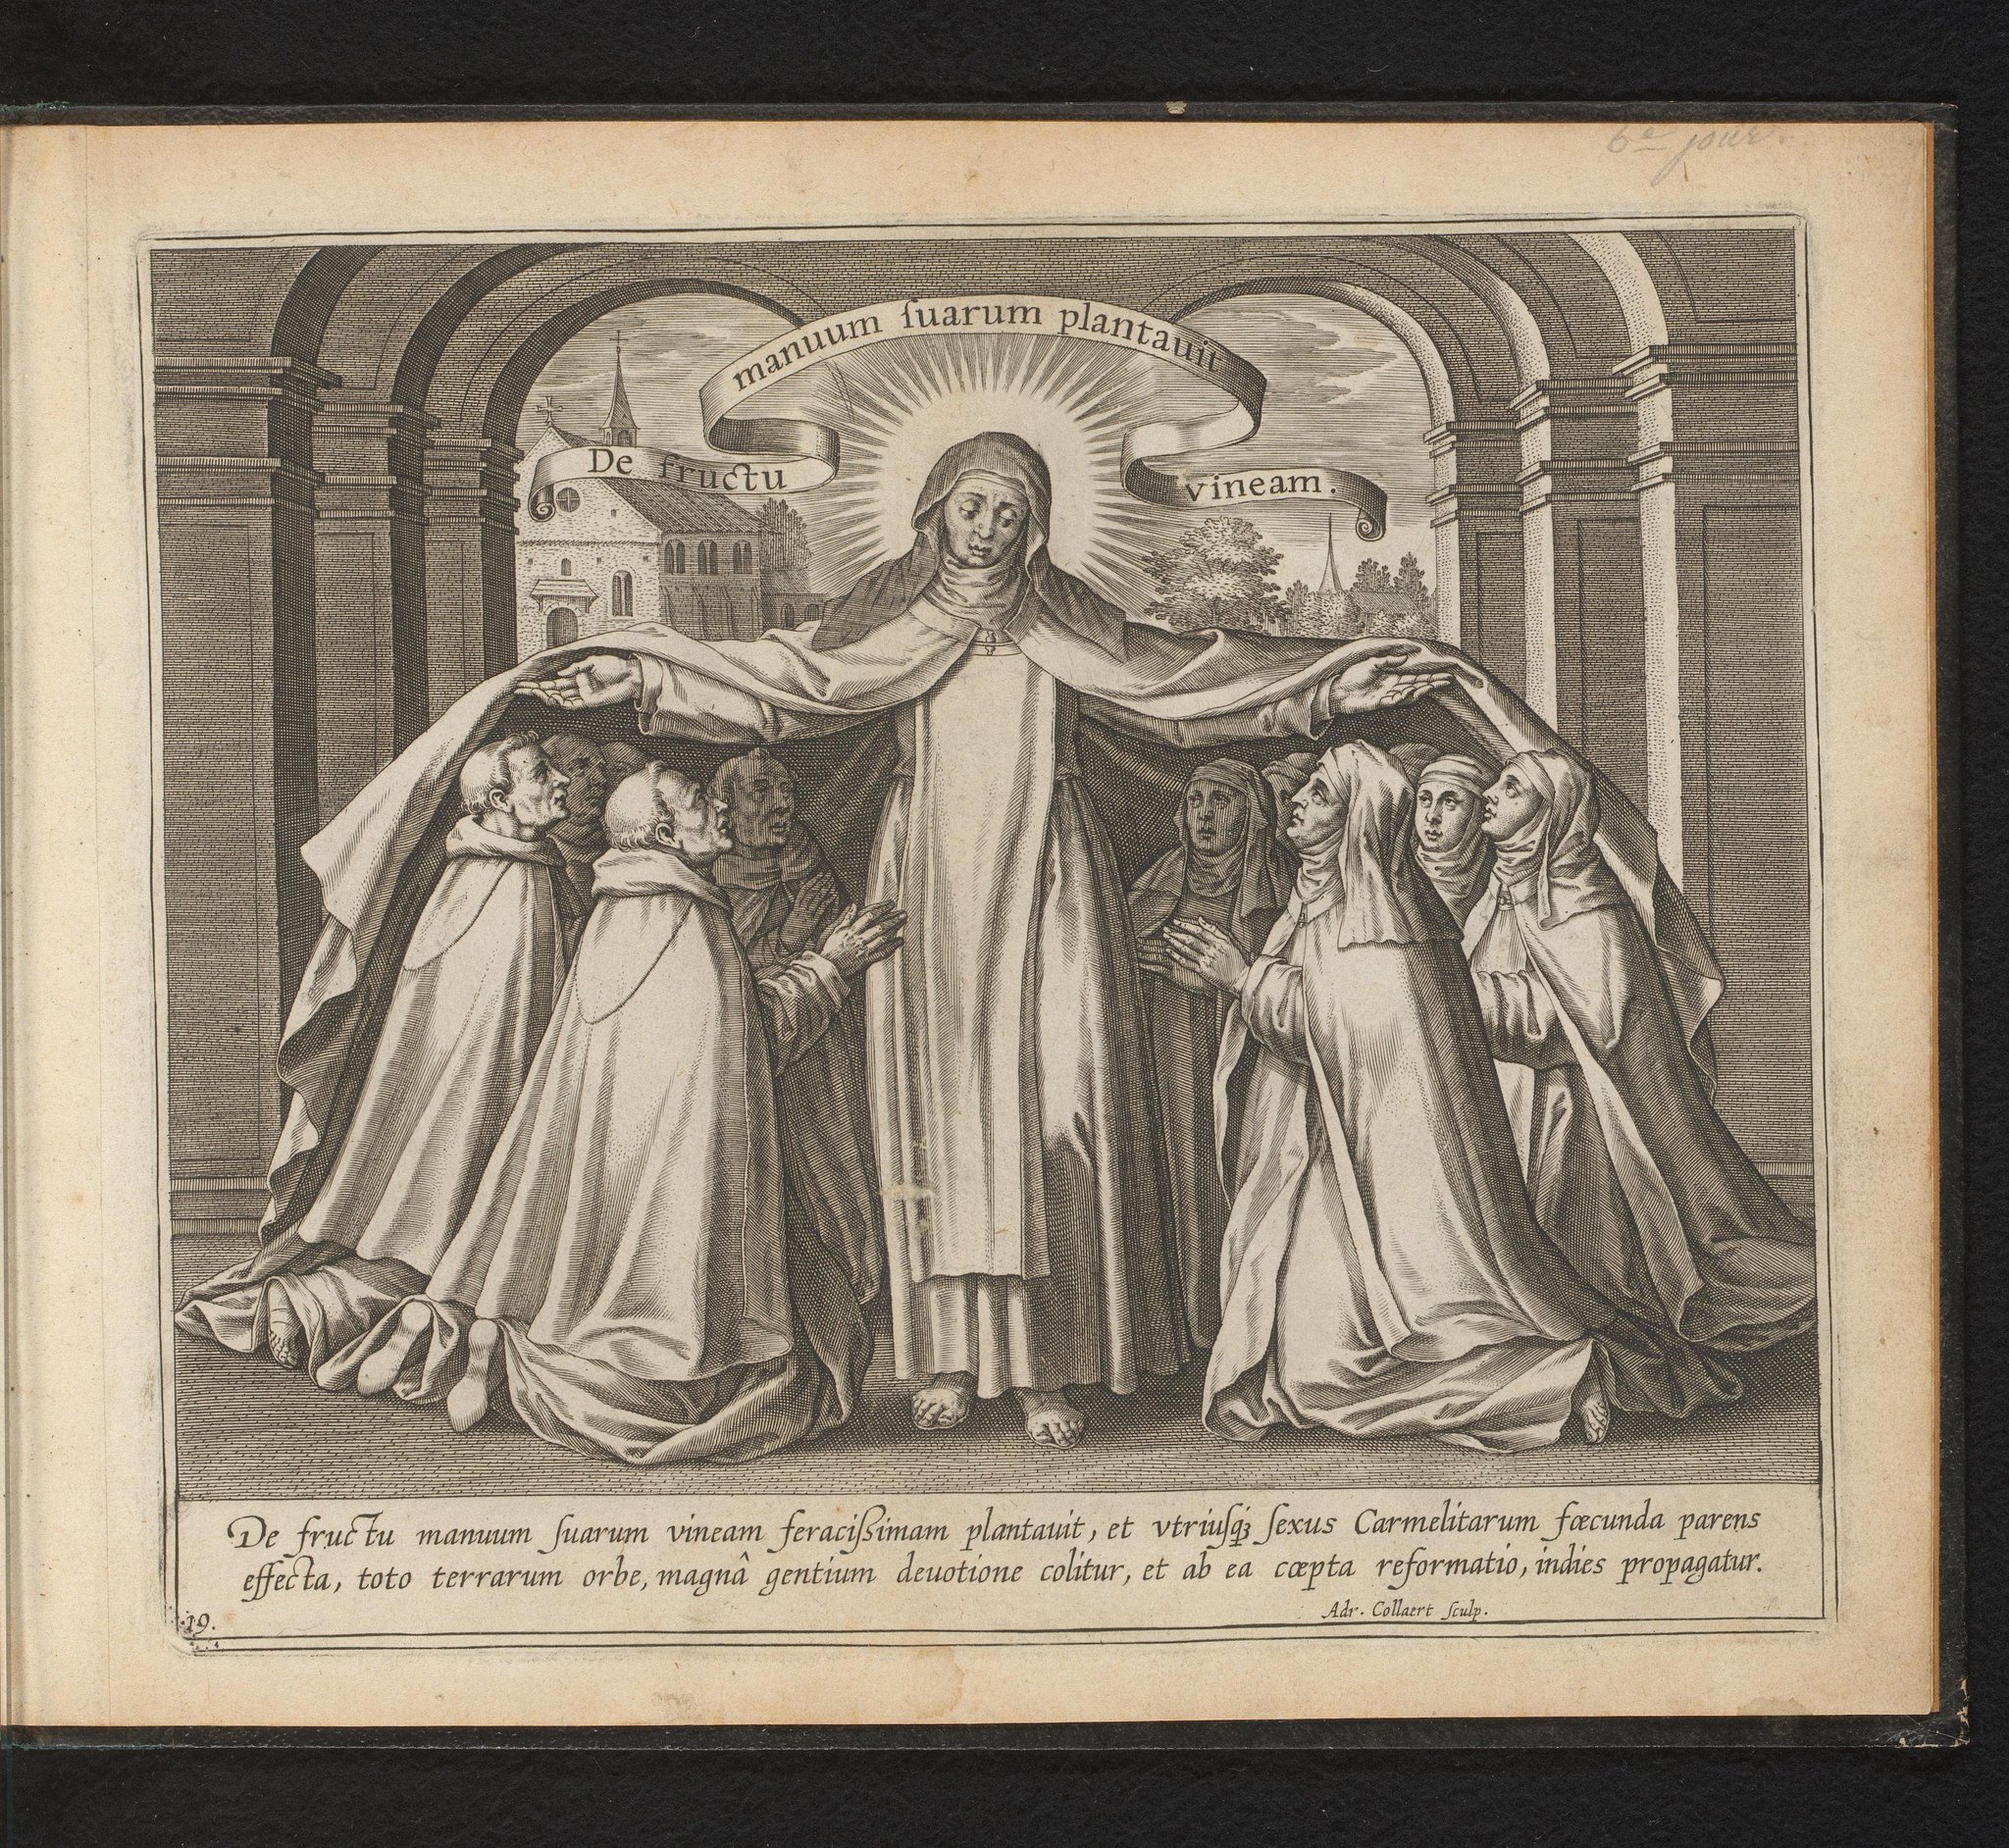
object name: print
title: Theresa als schutsheilige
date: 1613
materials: paper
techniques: engraving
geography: antwerp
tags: the foundress of the reformed (discalced) carmelites, t(h)eres(i)a of avila; possible attributes: angel, arrow, dove, heart (flaming or pierced by an arrow)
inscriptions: signature: ‘Adr. Collaert sculp.’, caption: ‘De fructu manuum...indies propagatur’, number: ‘19’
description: Prent in album 'Vita B. Virginis Teresiae A. Jesu ordinis carmelitarum excalceatorum piae restauratricis..., 1613.